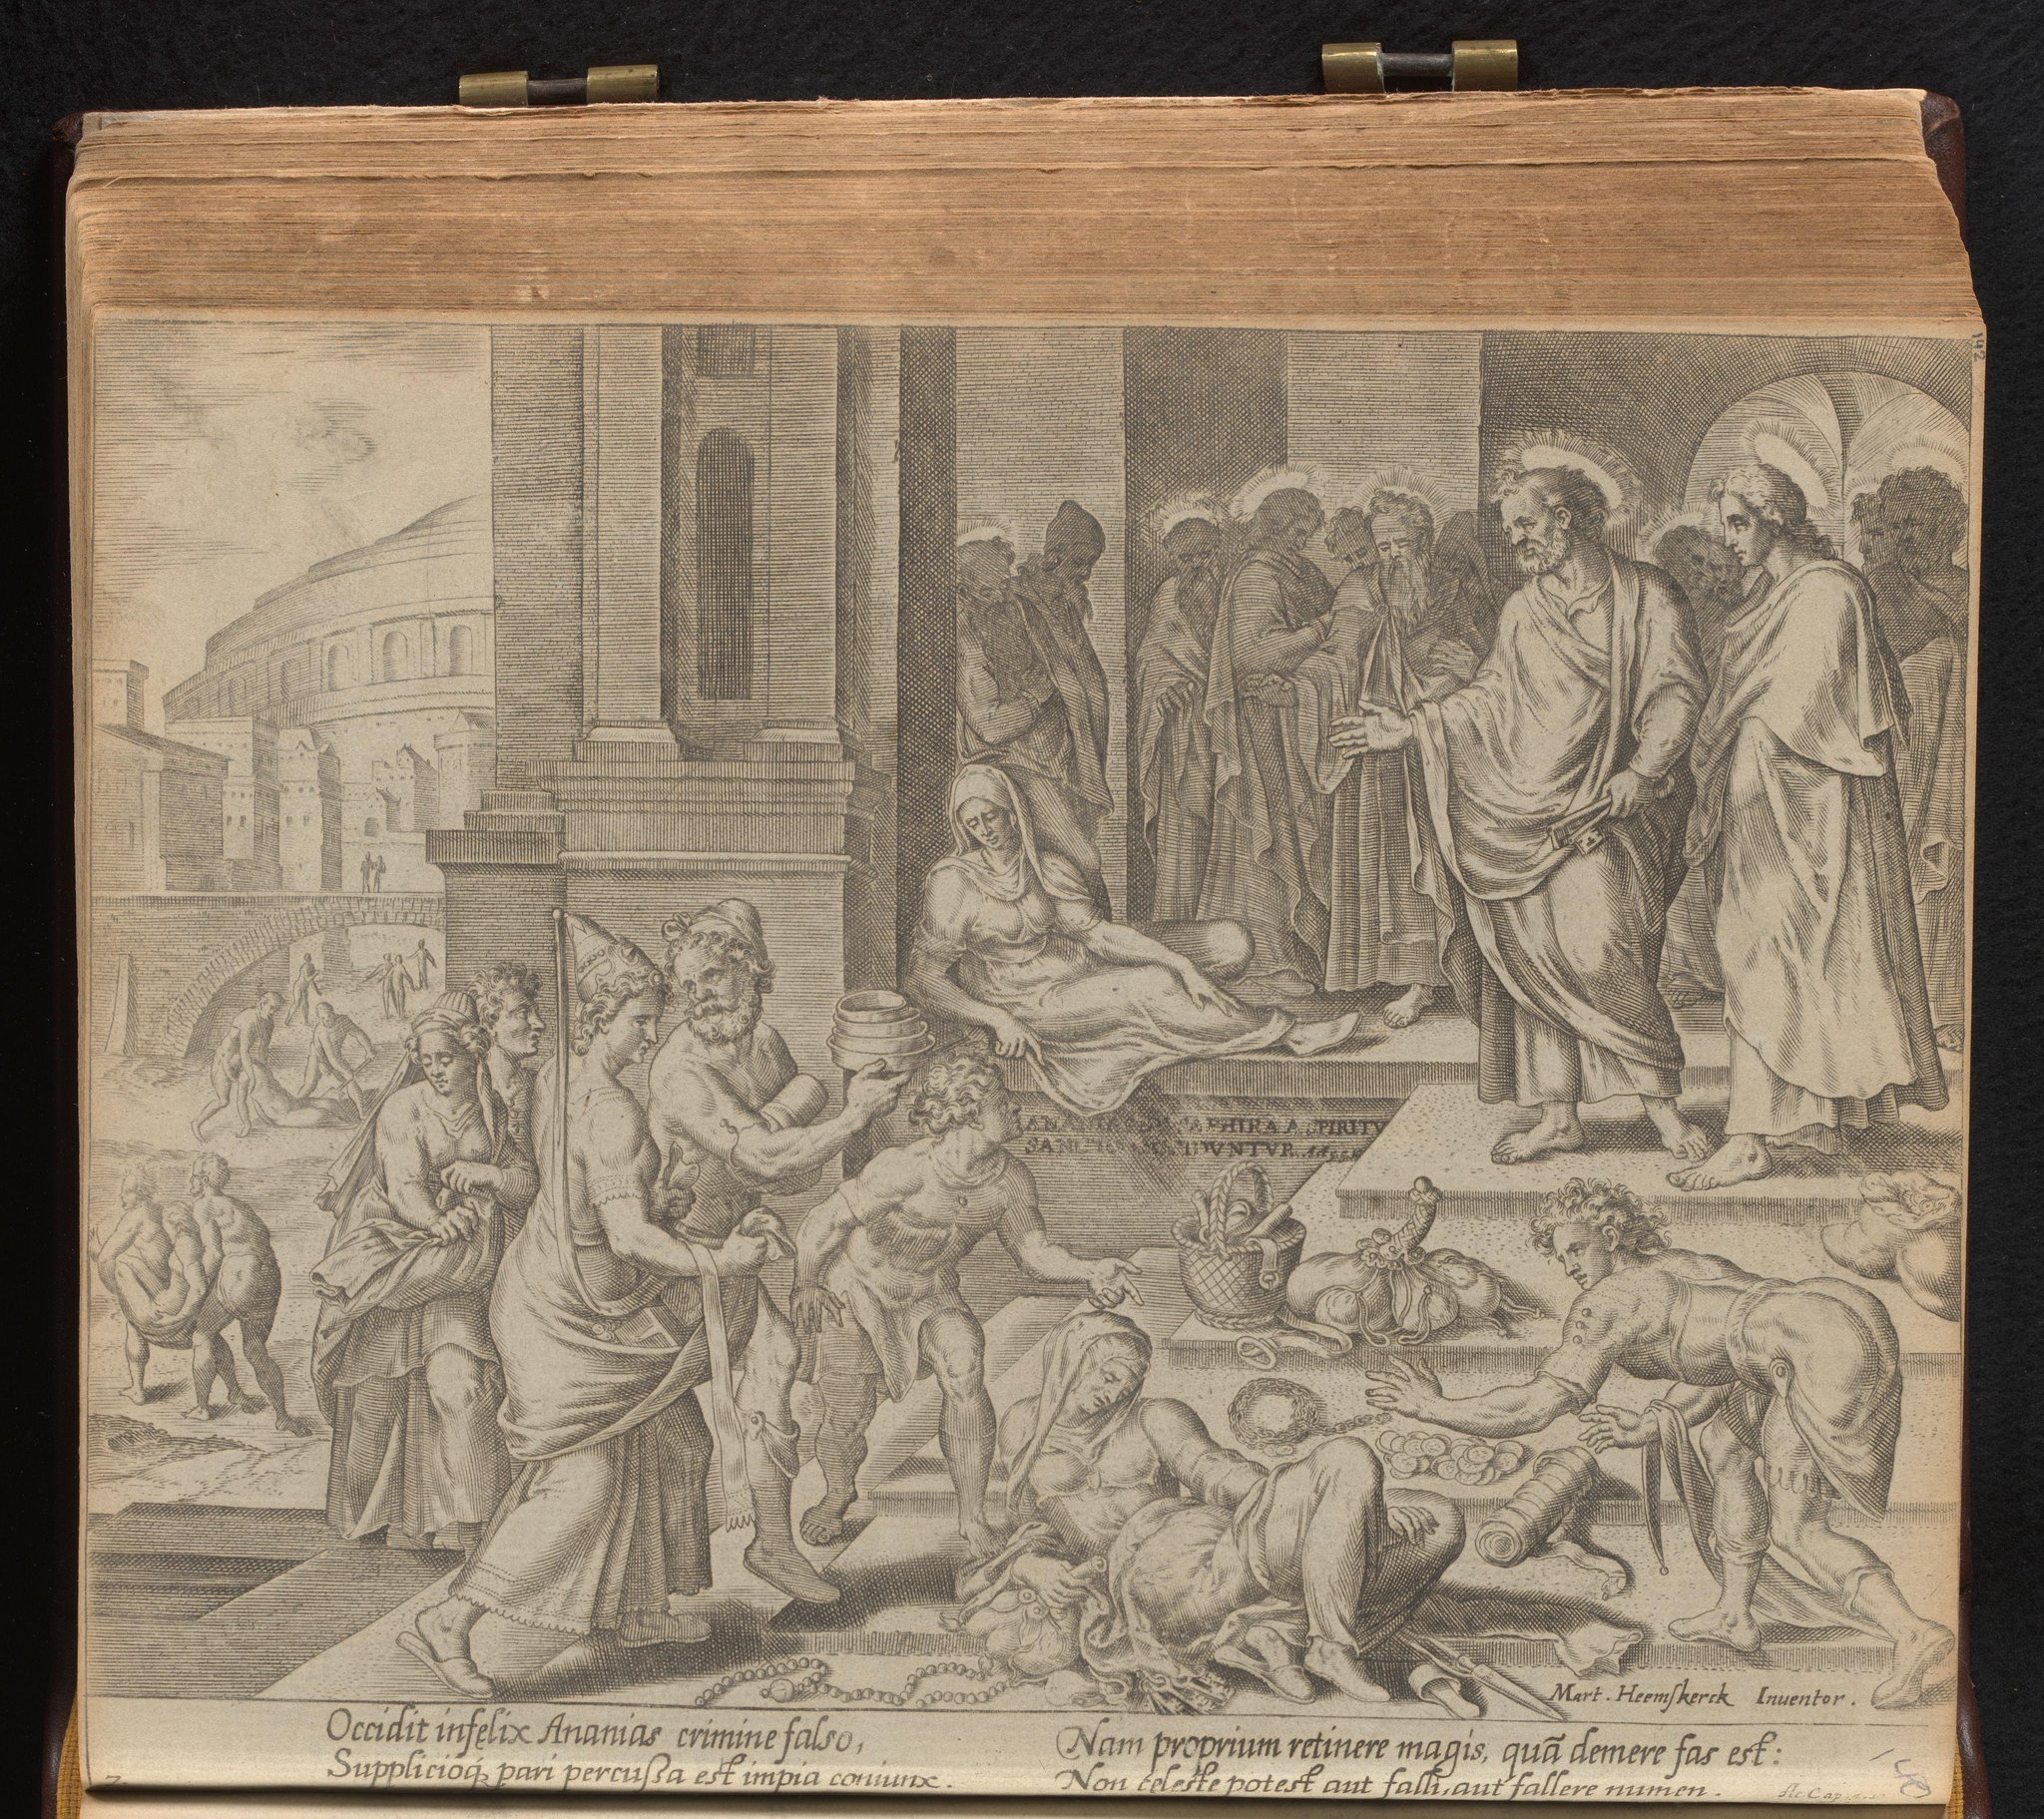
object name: titelprent, frontispice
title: Handelingen van de apostelen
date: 1575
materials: paper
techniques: engraving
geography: antwerp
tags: ananias carried away and buried by young men, peter questioning sapphira, who then dies too, sapphira carried away and buried by young men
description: Prent maakt deel uit van een prentbijbel.